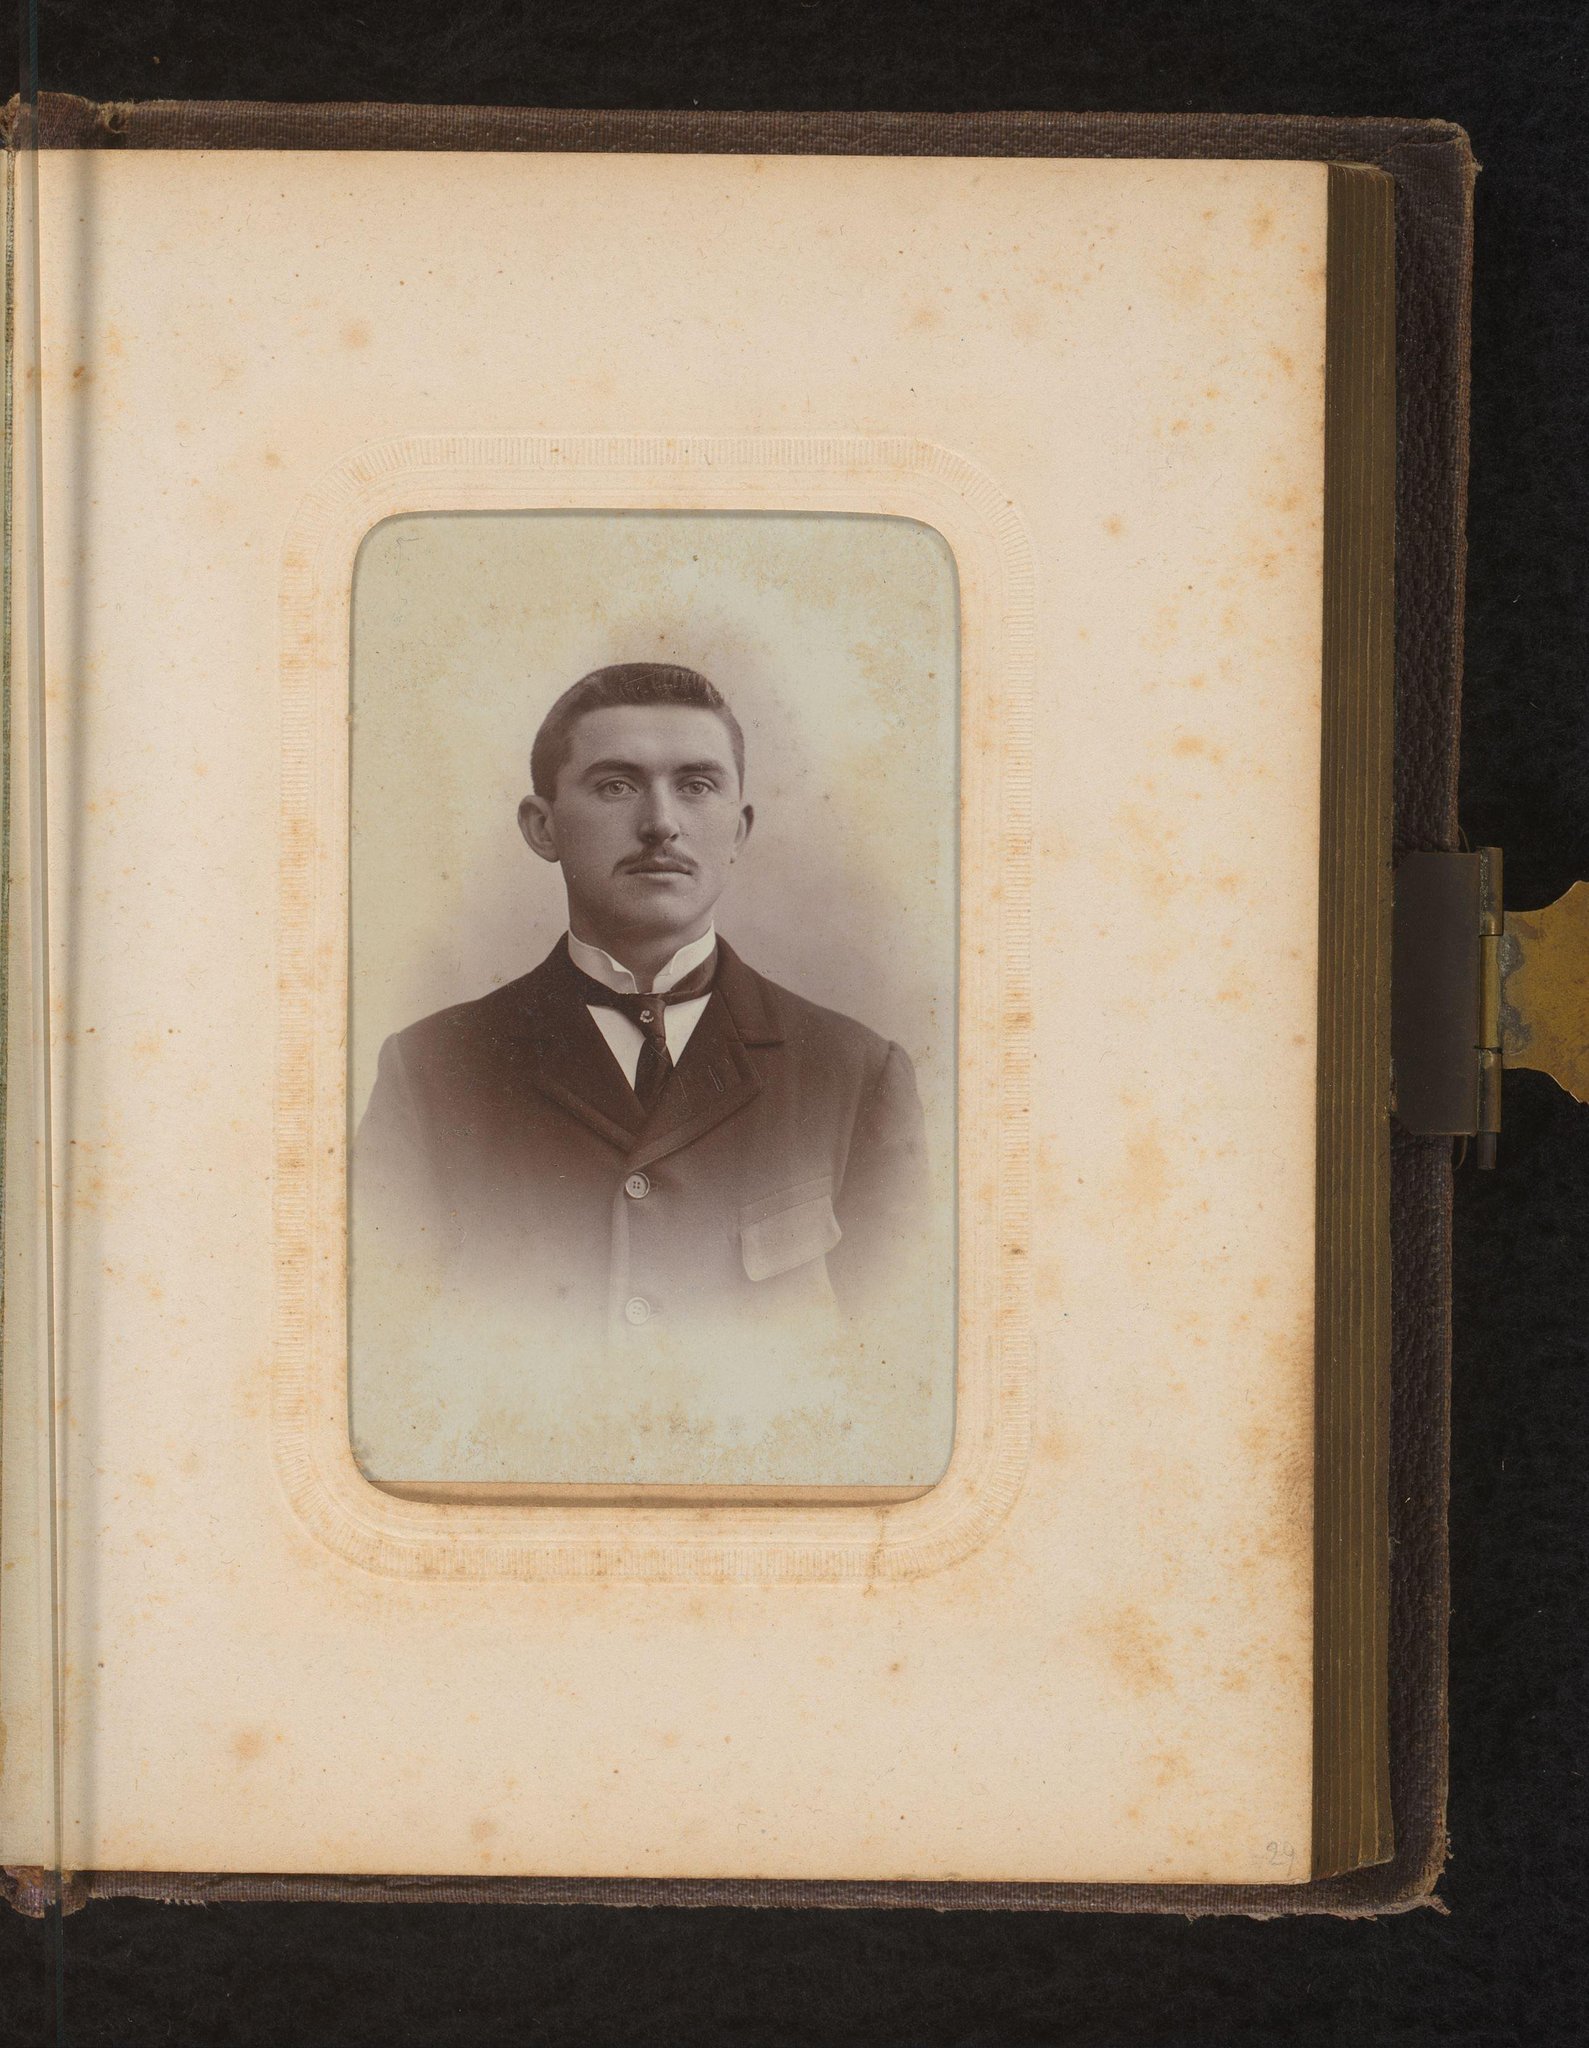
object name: album leaf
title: Portret van een man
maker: machiel hendricus laddé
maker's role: fotograaf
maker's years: 1866-1932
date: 1886-1892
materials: cardboard, photographic support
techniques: collodion silver print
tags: moustache, adult man, historical persons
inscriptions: inscription: ‘Photographie/ Artistique/ M.H. Laddé/ (...)/ Amsterdam/ 57-59/ Nieuwendijk’